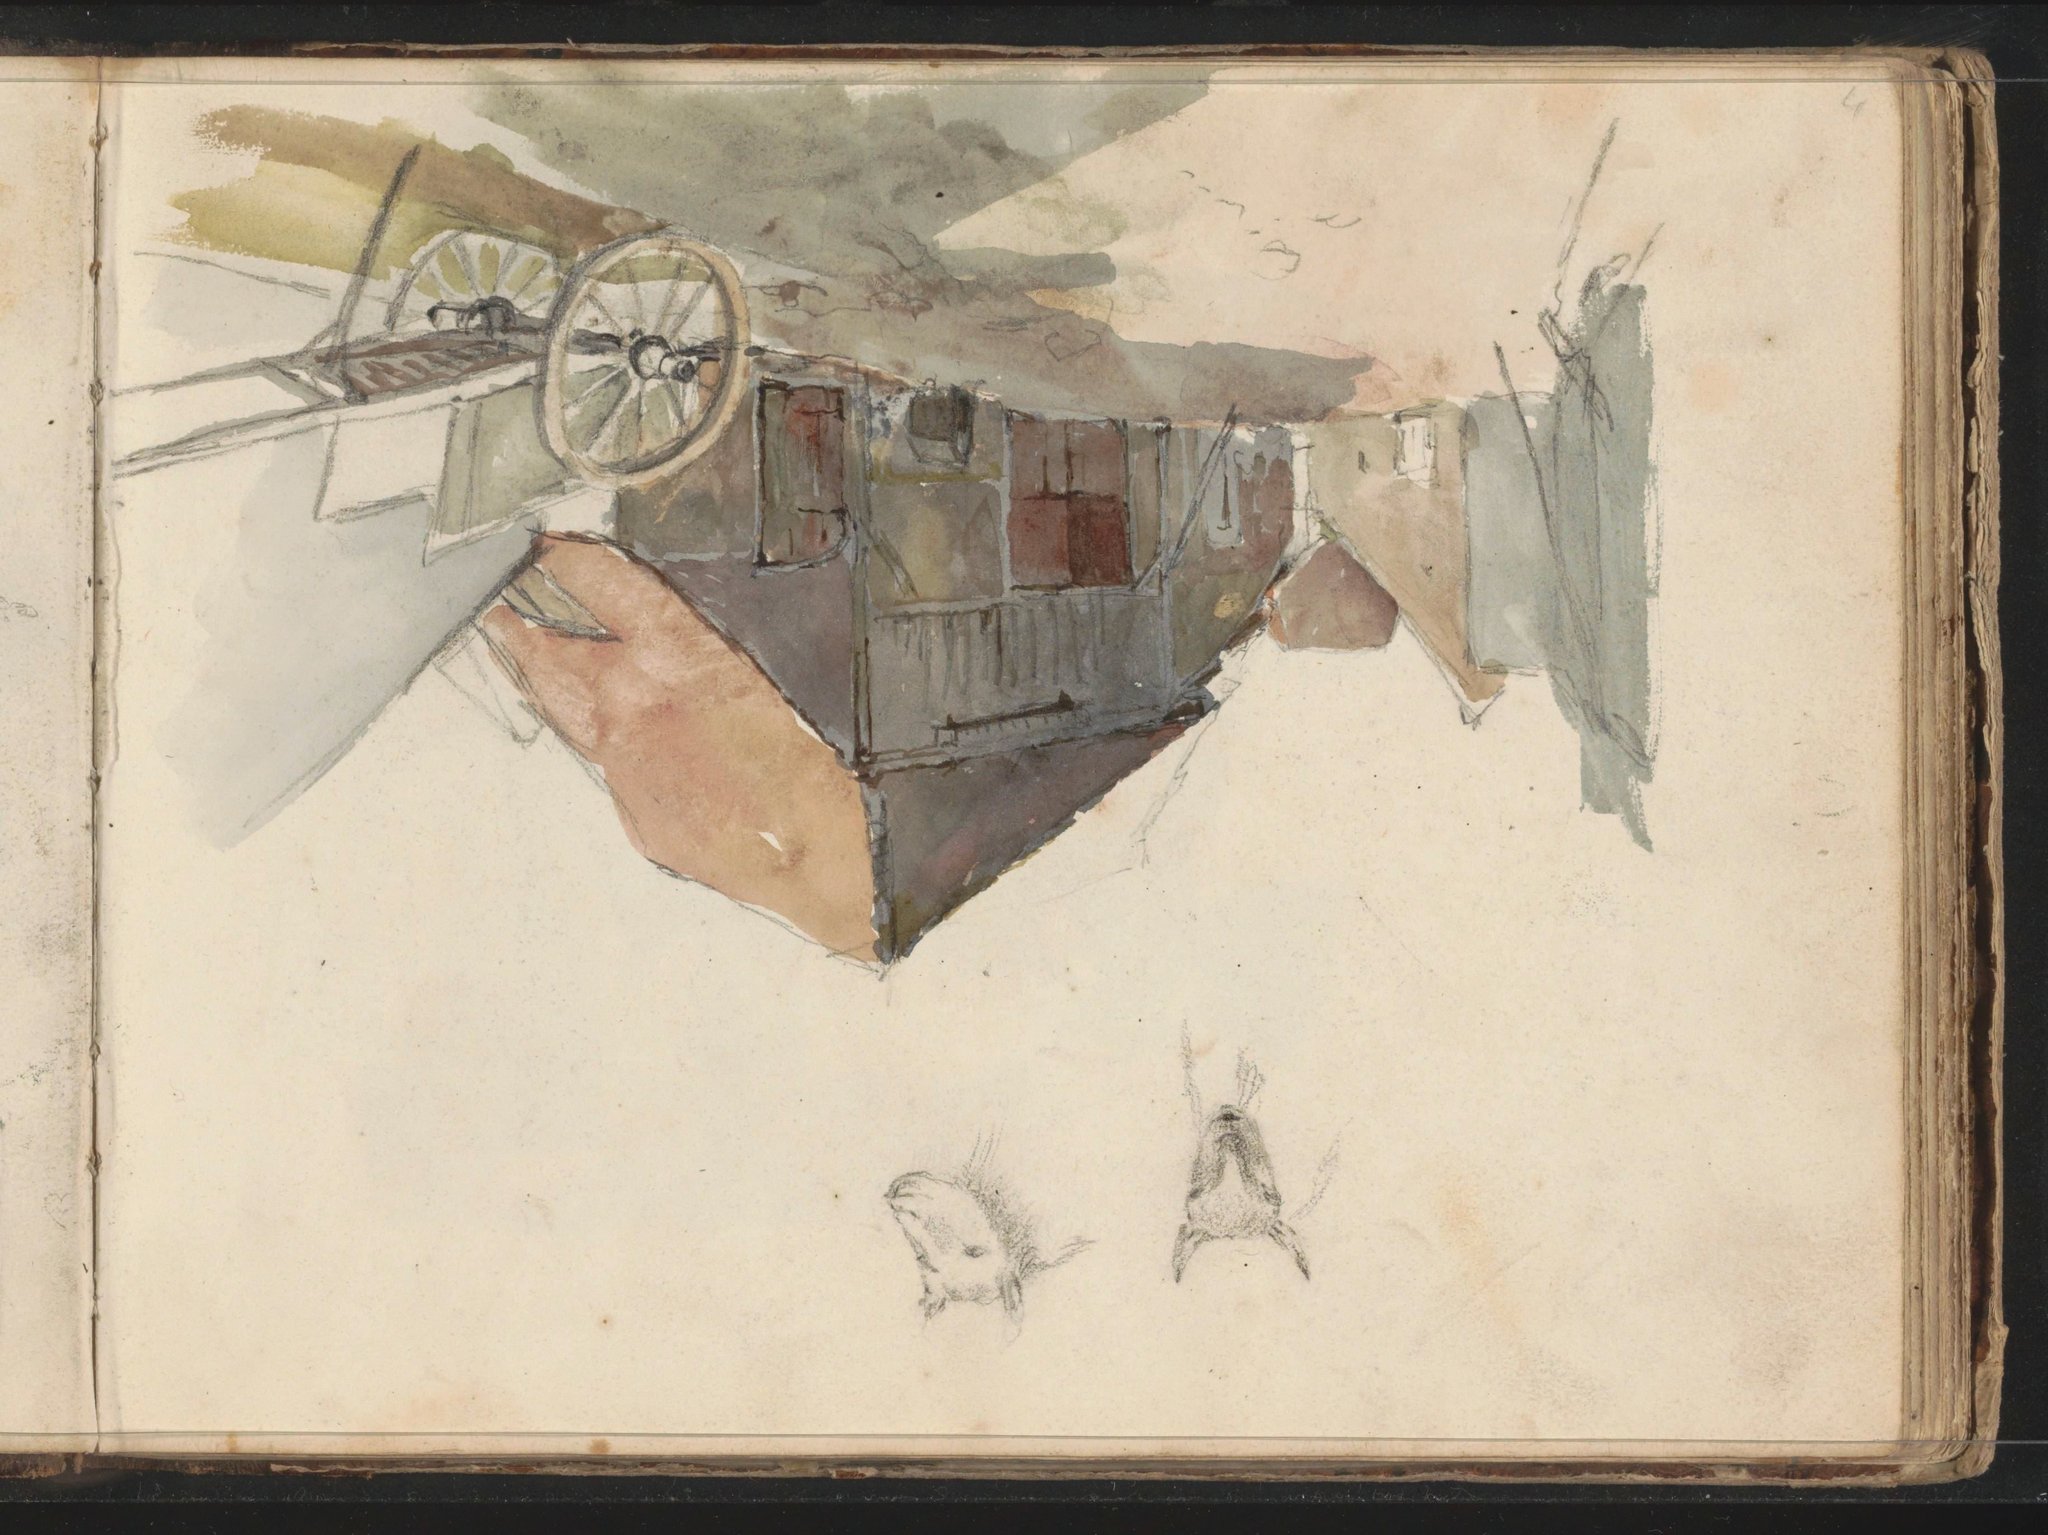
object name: sketchbook leaf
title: Handkar bij een schuur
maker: willem troost (ii)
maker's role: draughtsman, painter, print maker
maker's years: 1812-1893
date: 1822-1893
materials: chalk, paper, pencil, watercolor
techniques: brush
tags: hand-cart, barn, goat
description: Tevens twee studies van geitenkoppen. Blad 4 recto uit een schetsboek met 36 bladen.